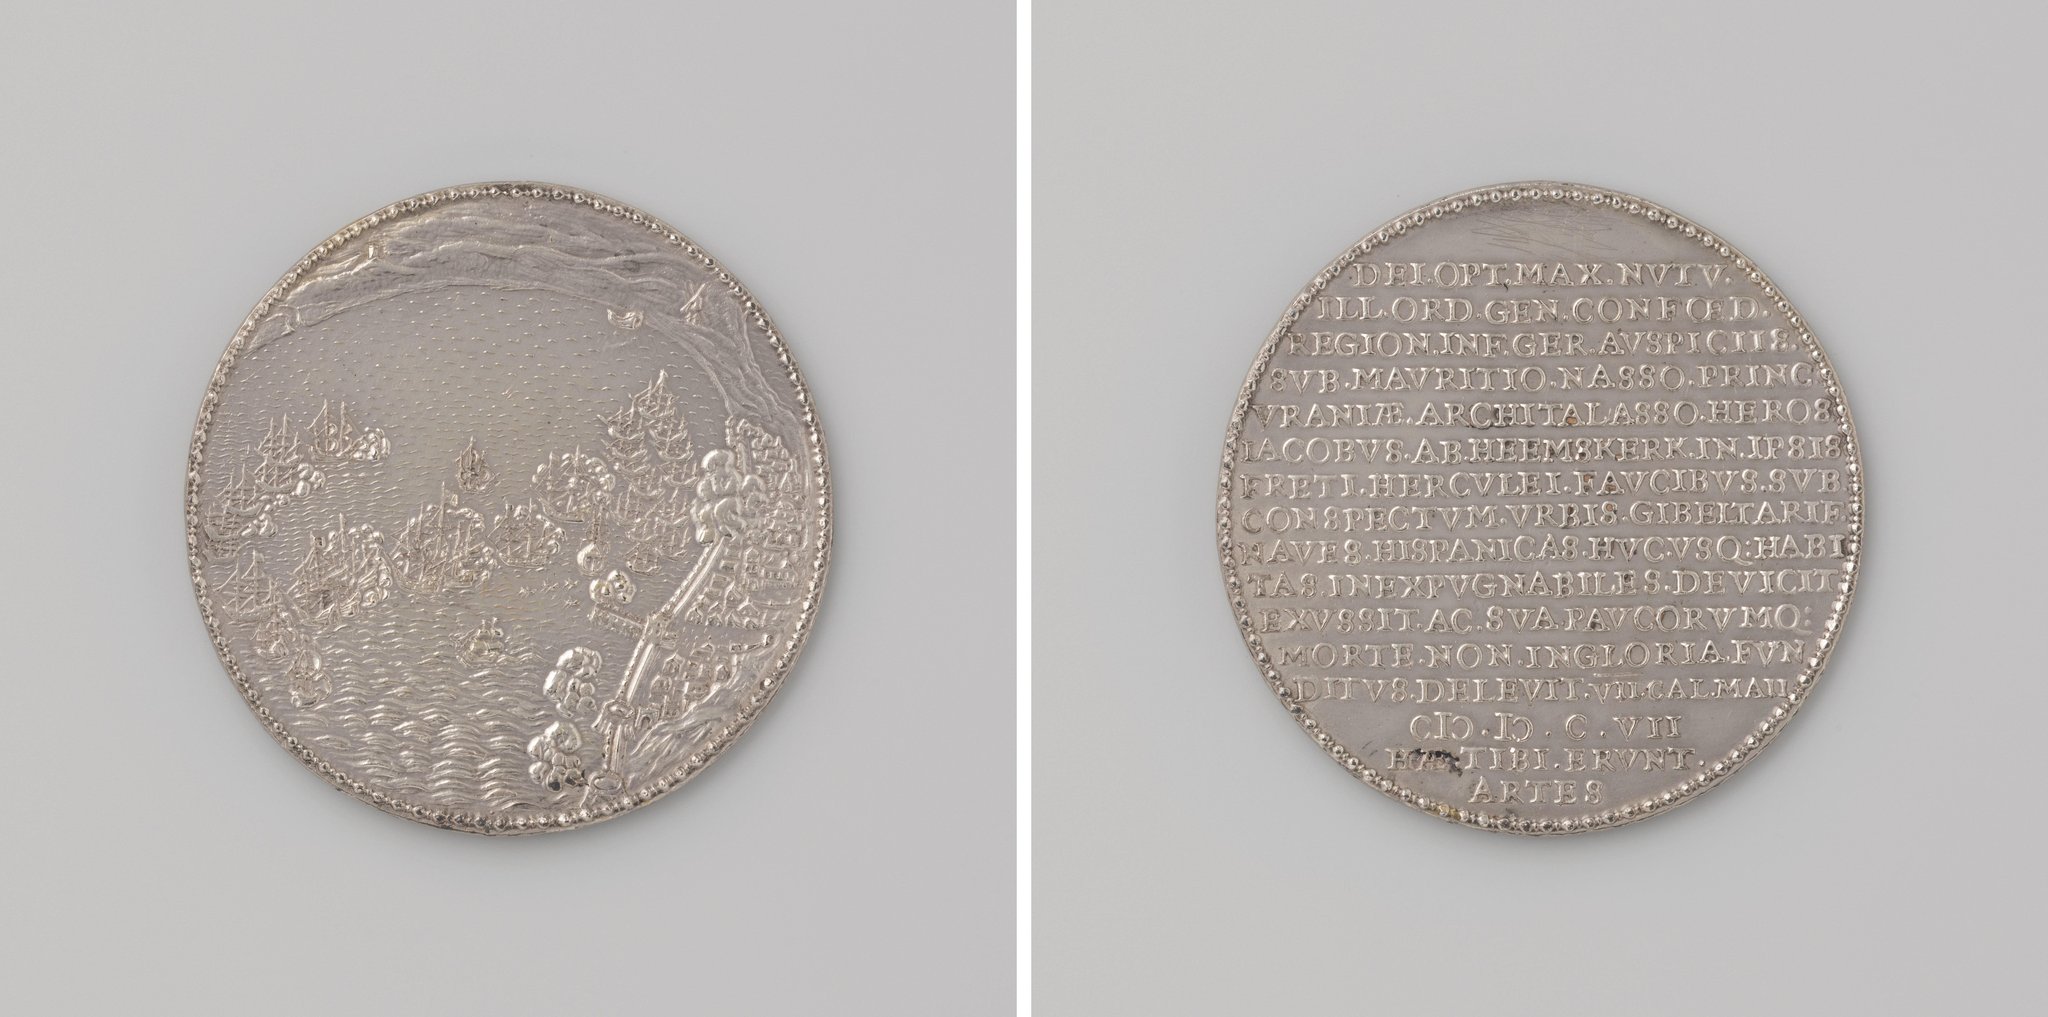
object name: triomfpenning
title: Zeeslag bij Gibraltar en het sneuvelen van admiraal van Heemskerck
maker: gerard van bylaer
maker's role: die cutter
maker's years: 1540-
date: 1607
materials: silver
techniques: striking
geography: dordrecht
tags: amsterdam, jacob van heemskerck, battle (+ naval force)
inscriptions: inscription: ‘DEI OPT MAX NVTV ILL ORD GEN CONFOED REGION INF GER AVSPICIIS SVB MAVRITIO NASSO PRINC VRANIAE ARCHITALASSO HEROS IACOBVS AB HEEMSKERK IN IPSIS FRETI HERCVLEI FAVCIBVS SVB CONSPECTVM VRBIS GIBELTARIF NAVES HISPANICAS HVCVSQ HABITAS IN EXPVGNABILES DEVICIT EXVSSIT AC SVA PAVCORVMQ MORTE NON INGLORIA FVNDITVS DELEVIT VII CAL MAII MDCVII / HAE TIBI ERVNT ARTES’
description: Zilveren penning. Voorzijde: zeeslag in baai. Keerzijde: opschrift.